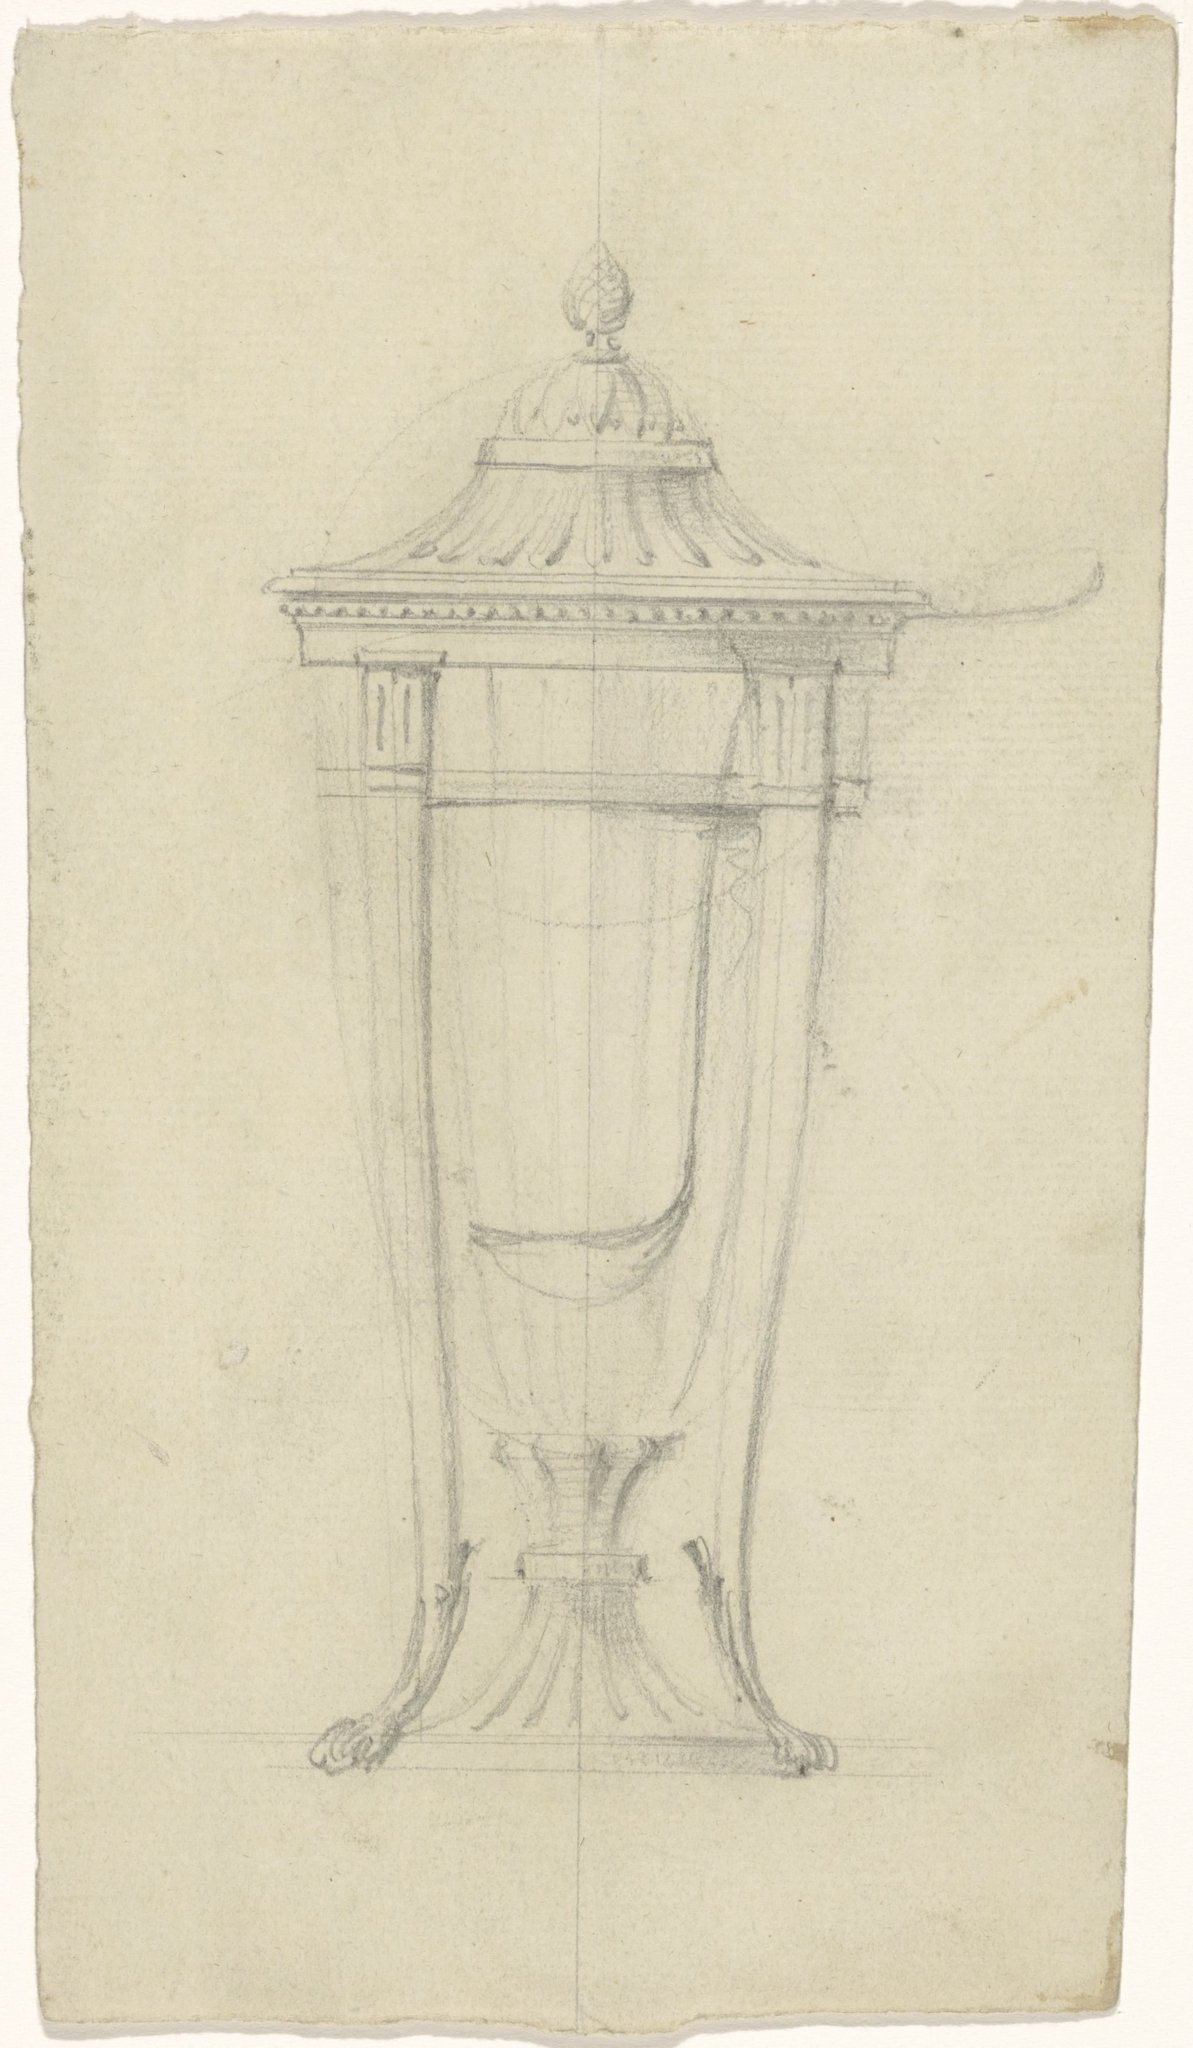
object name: design drawing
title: Ontwerp voor een mosterdpot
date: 1780-1790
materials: graphite, paper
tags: spice-box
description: Ontwerp voor een mosterdpot van glas met een montuur van zilver, met daarin een lepeltje, grafiet.